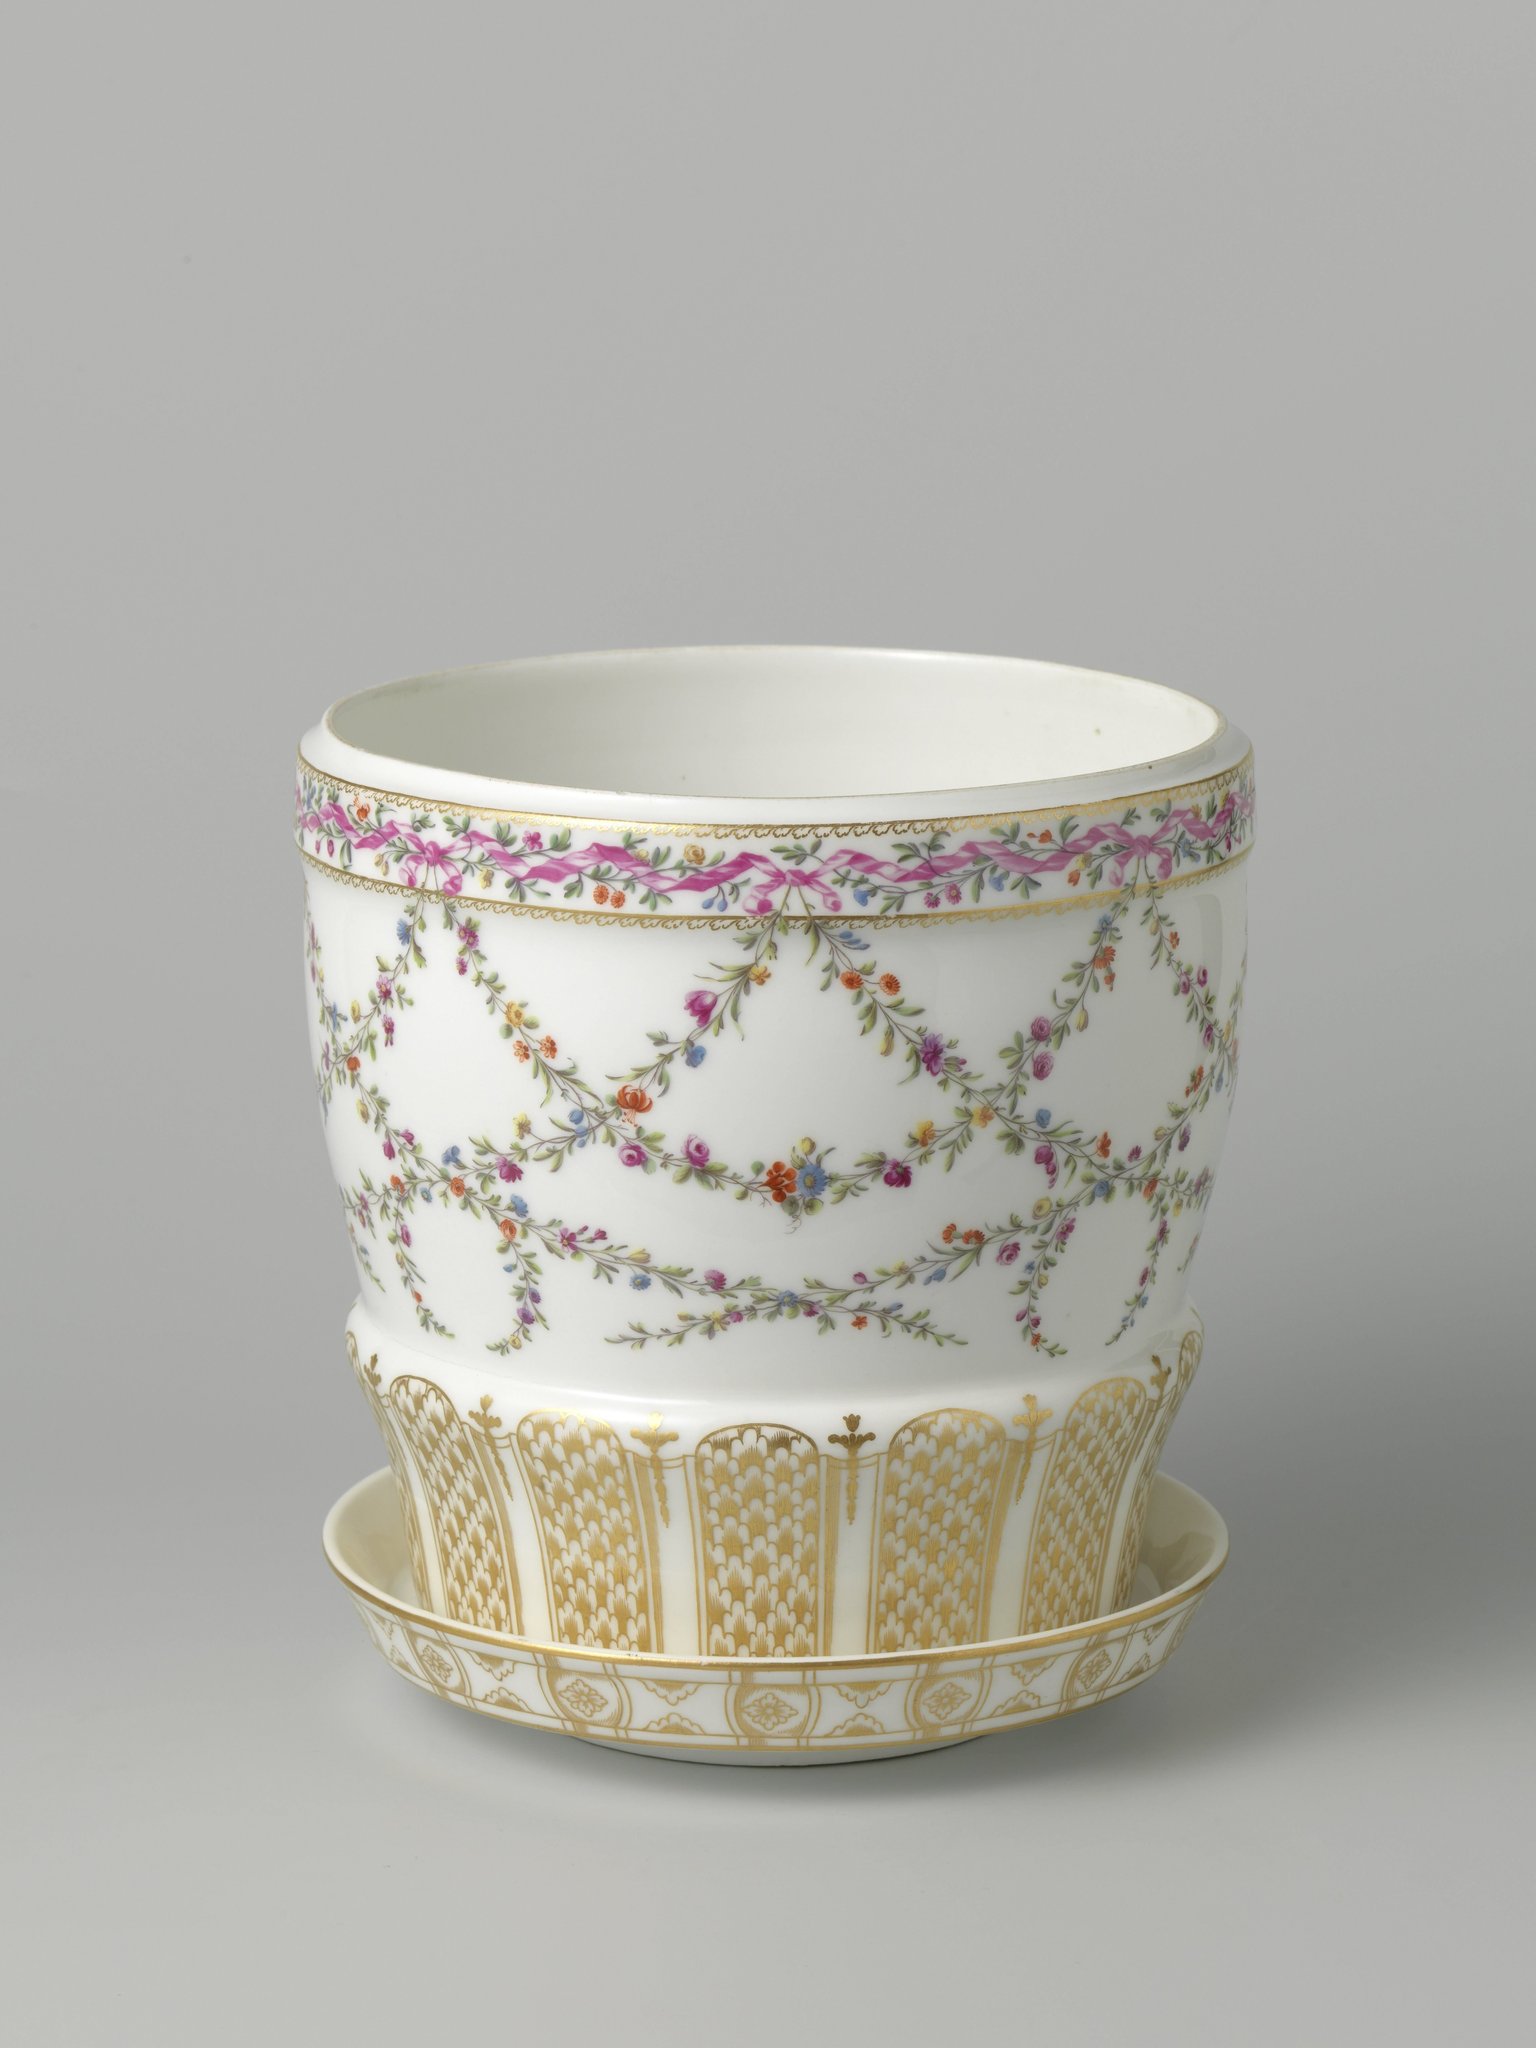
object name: platter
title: Two wine coolers and stands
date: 1778-1782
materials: porcelain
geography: loosdrecht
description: Manufactuur Oud-Loosdrecht Loosdrecht, c. 1778–1782 hard-paste porcelain